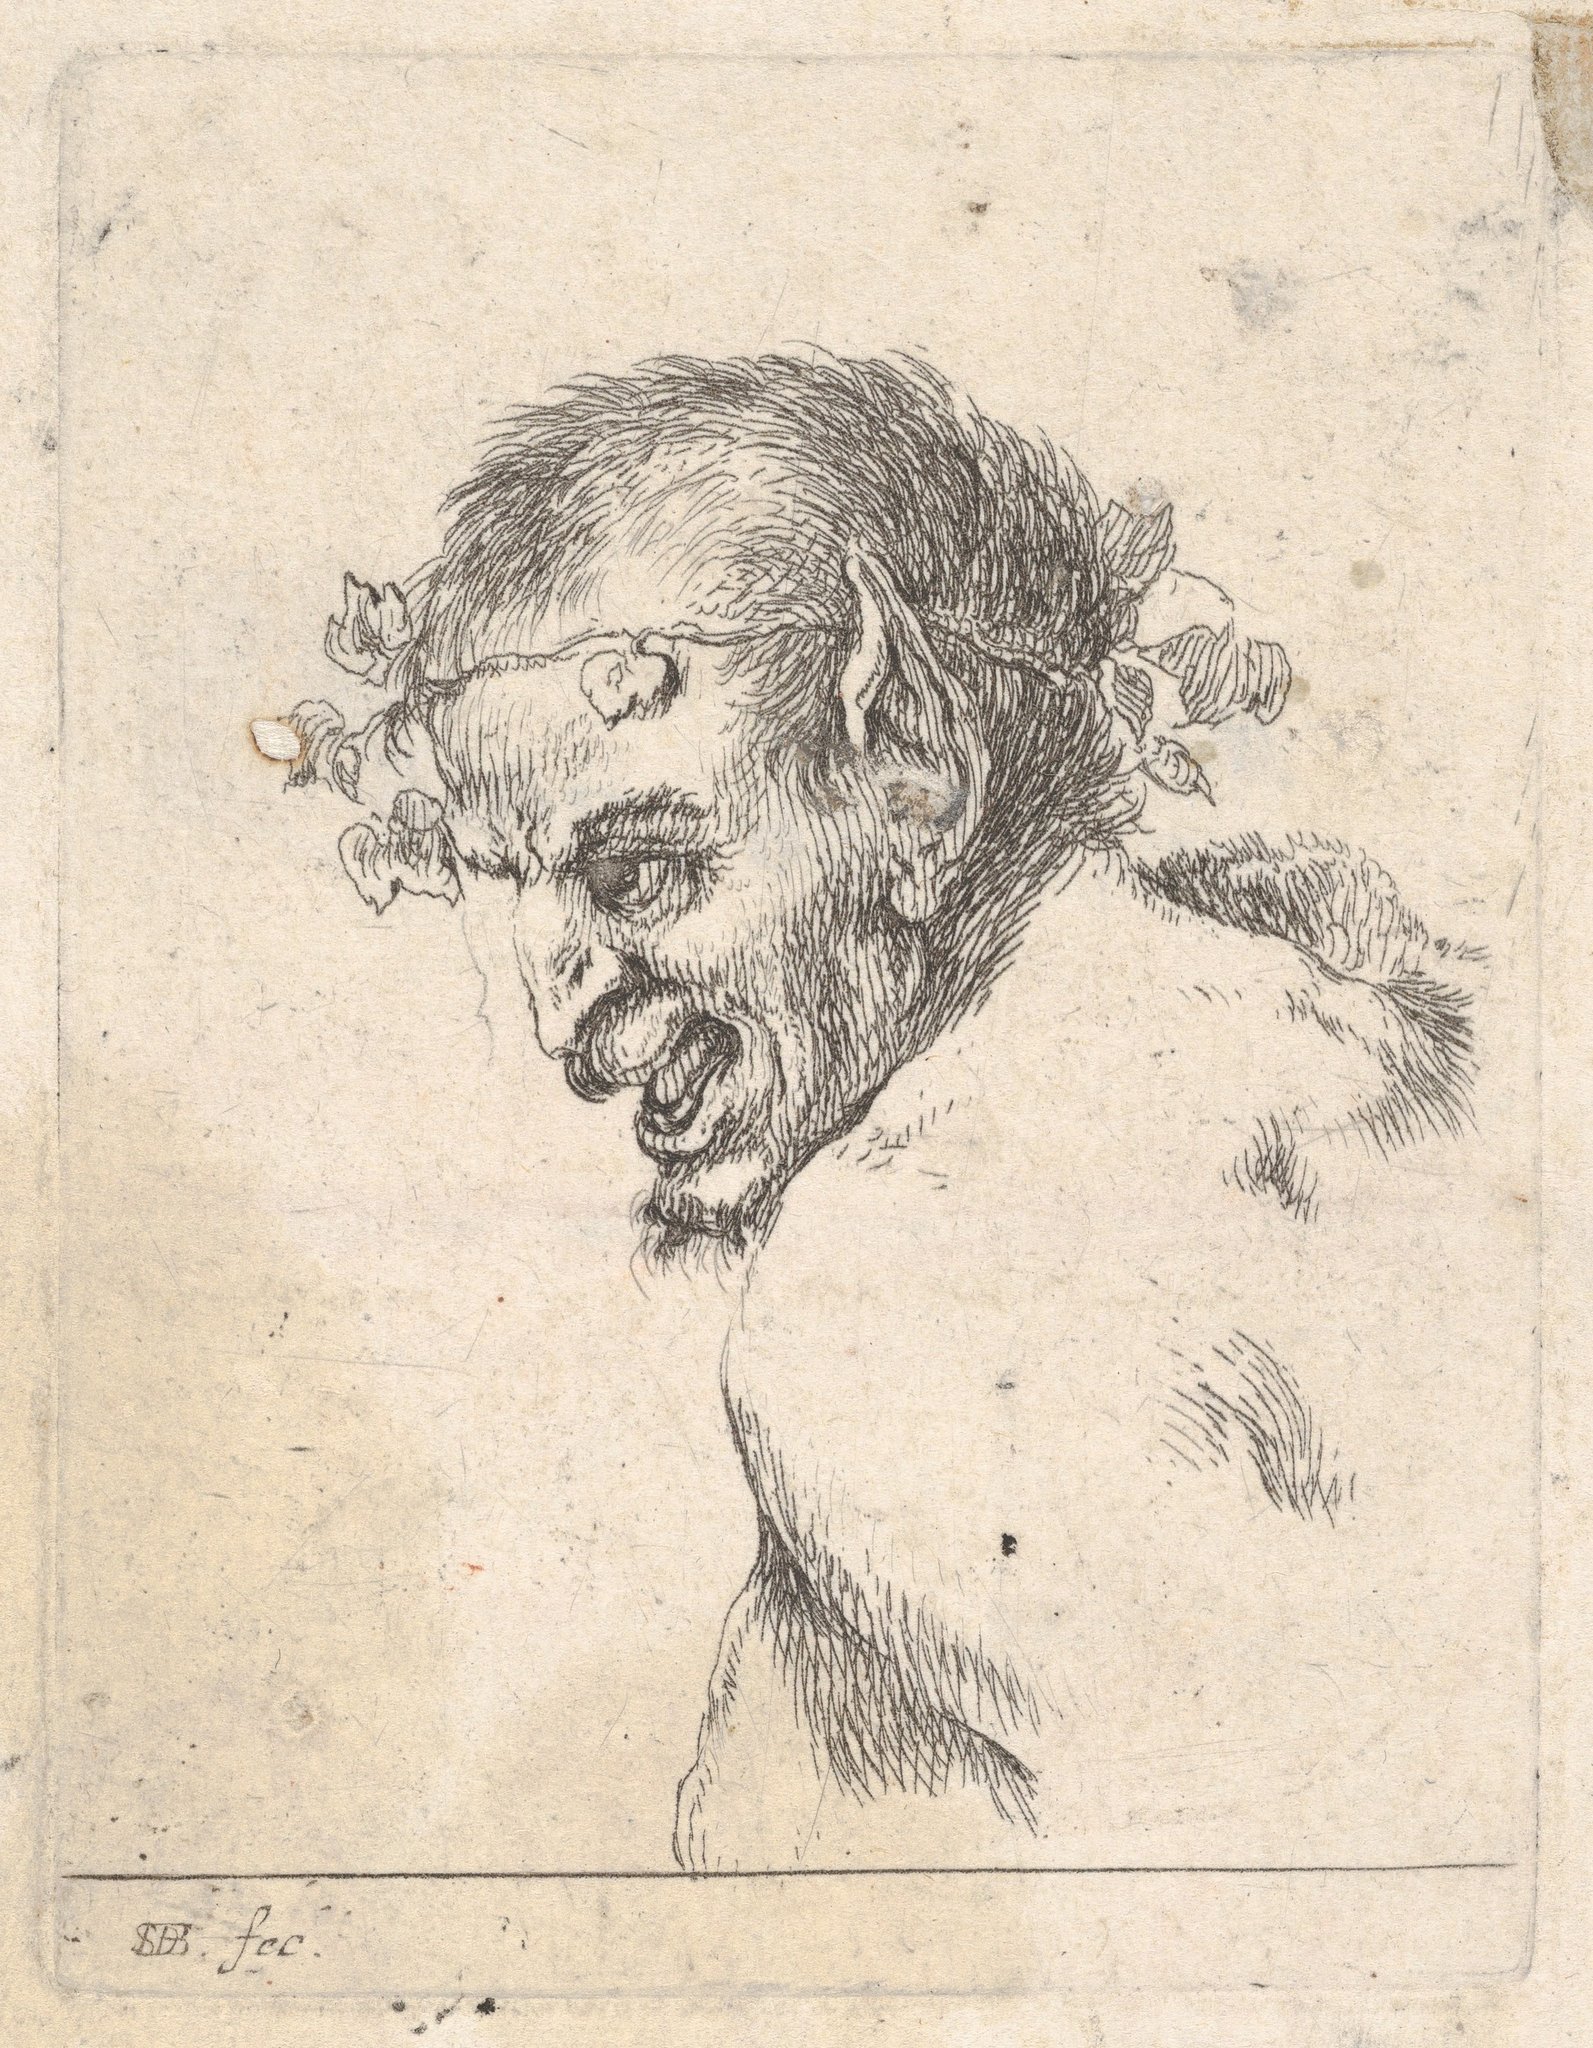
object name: print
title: Bust of a laughing satyr, facing left in profile, plate 29 from "Various Portraits" (Recueil de diverses pièces servant à l'art de portraiture)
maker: stefano della bella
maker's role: artist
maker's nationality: italian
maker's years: 1610-1664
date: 1647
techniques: etching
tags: satyrs